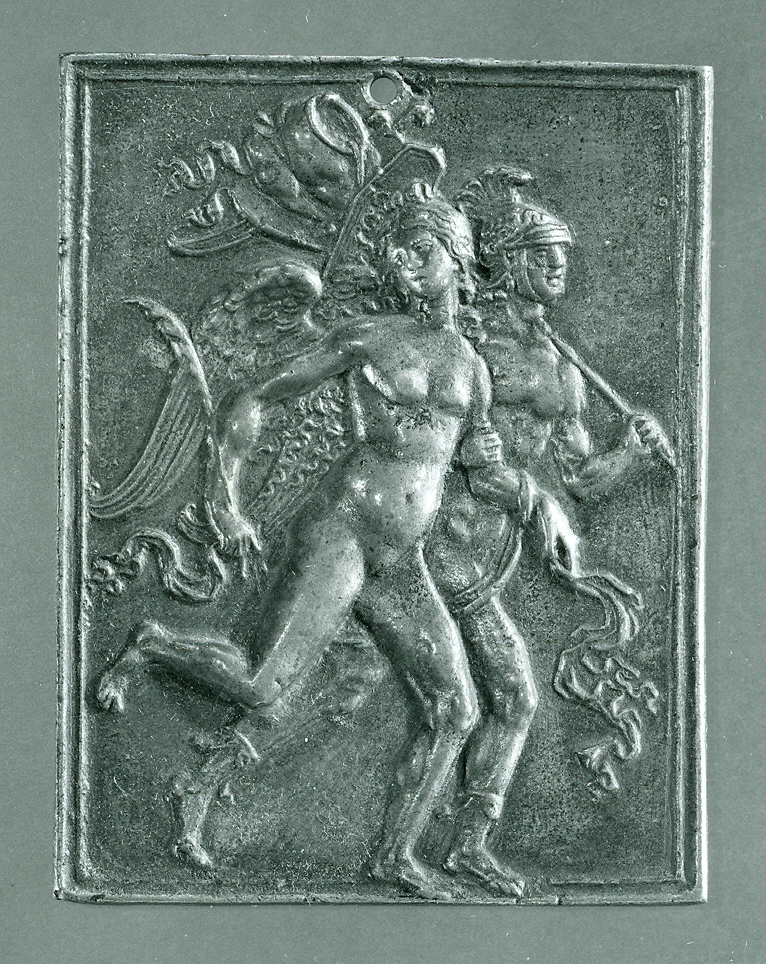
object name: plaquette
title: Mars and Victory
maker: moderno (galeazzo mondella)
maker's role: artist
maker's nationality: italian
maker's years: 1467-1528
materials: copper alloy, patina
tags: victory